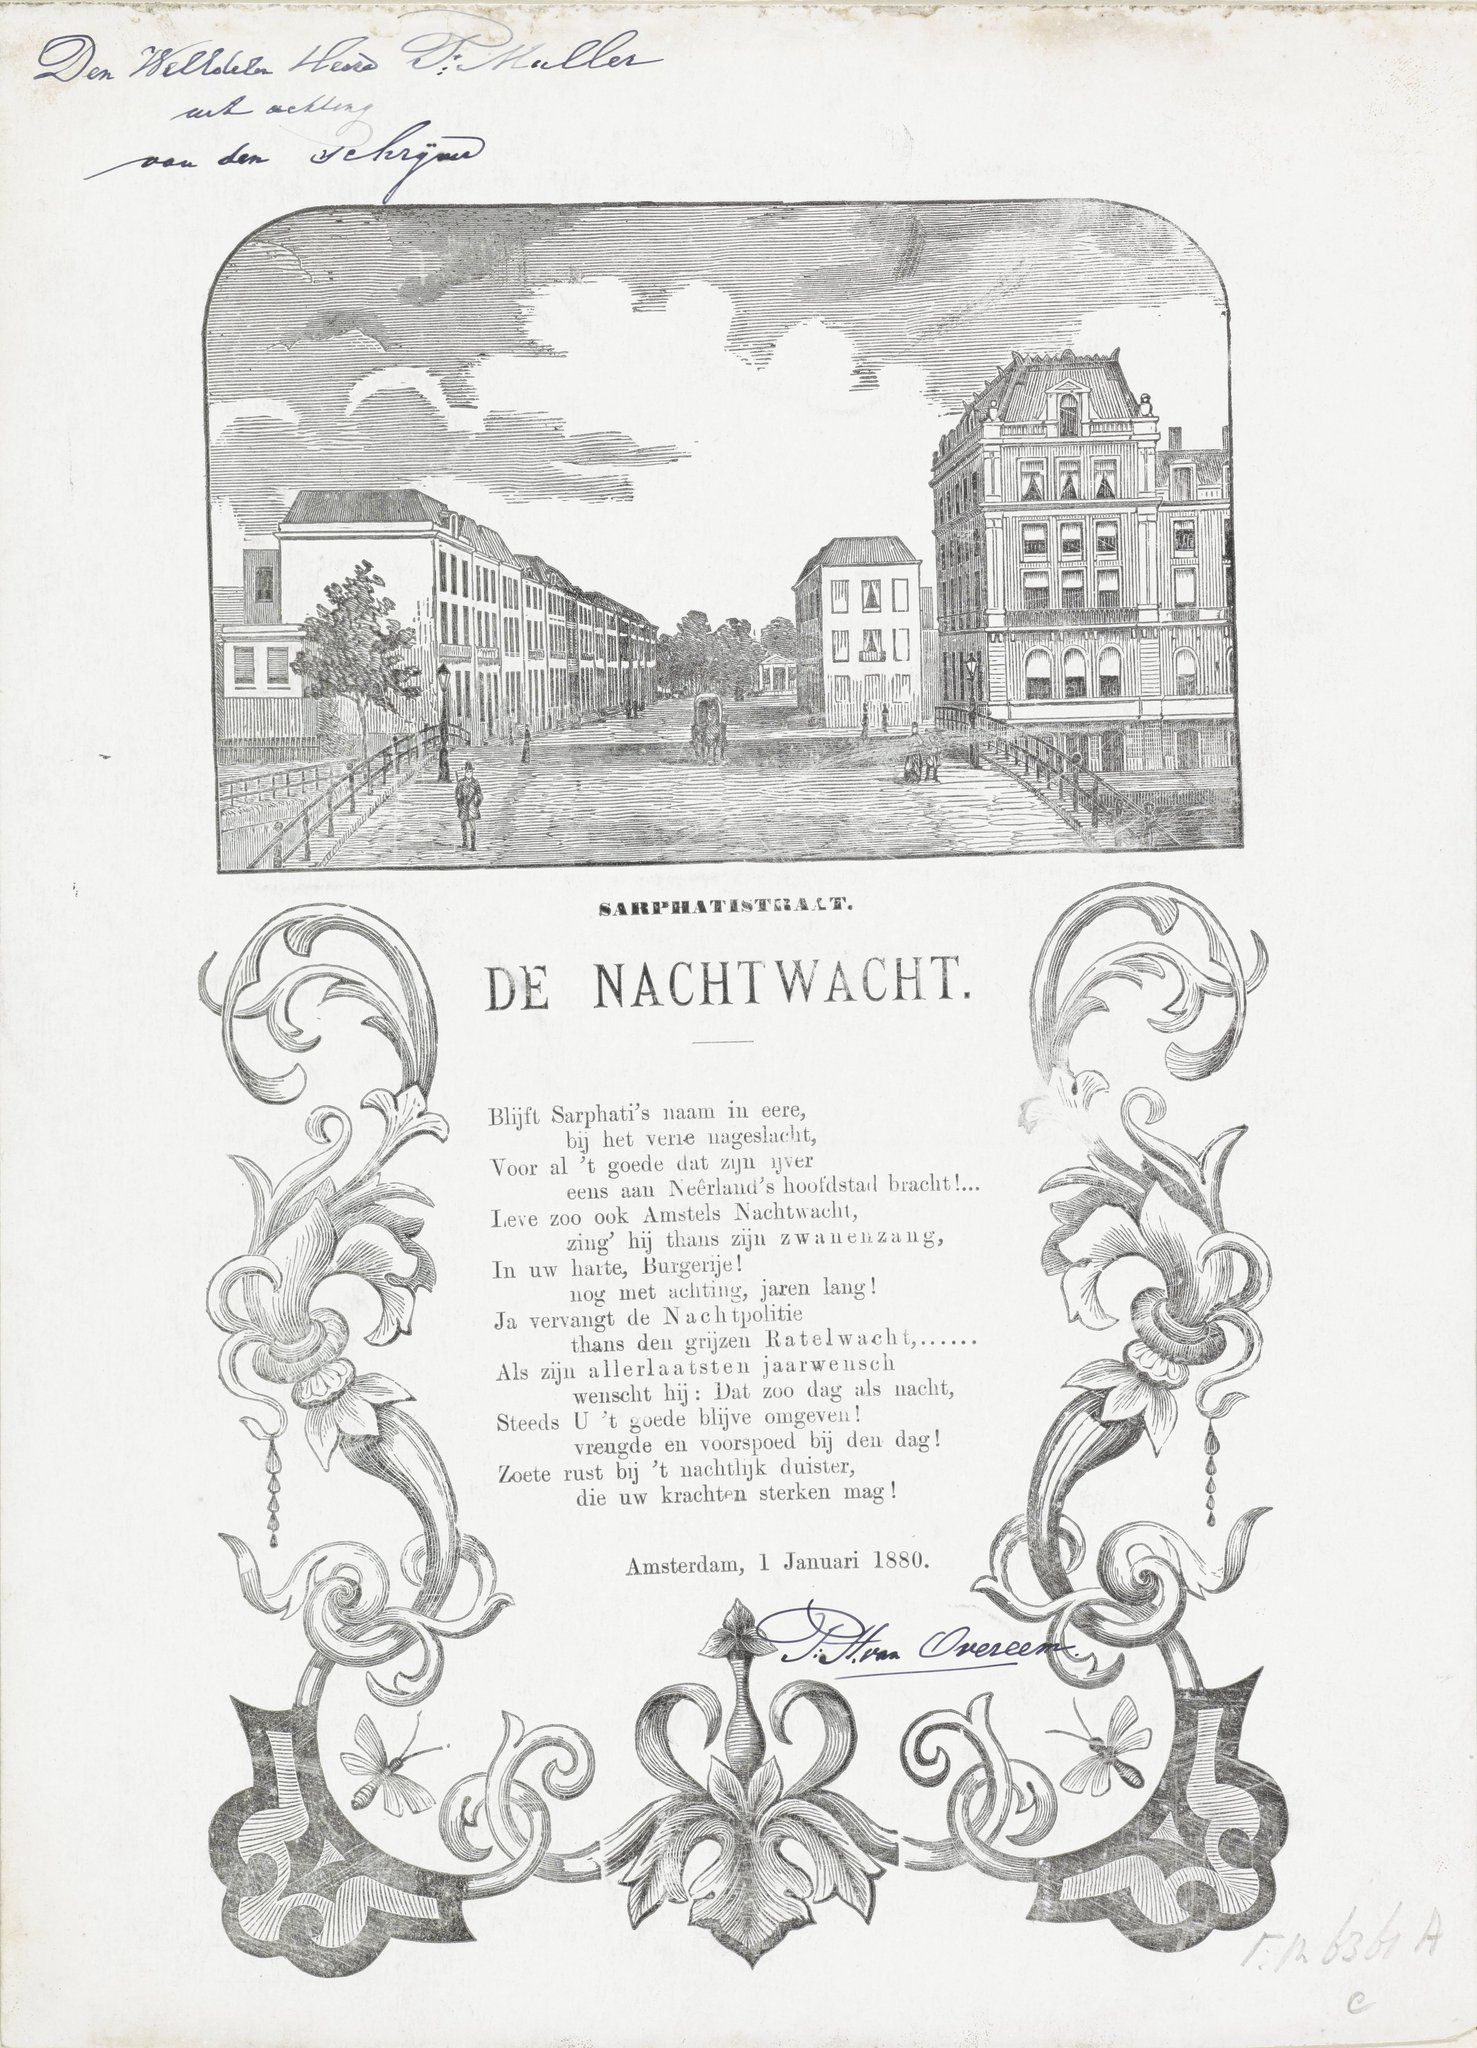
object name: new year card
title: De Nachtwacht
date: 1879-1880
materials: paper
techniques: letterpress printing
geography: amsterdam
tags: night patrol, street, amsterdam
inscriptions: collector's mark: Lugt 2228, signature: ‘PA van Overeem’, inscription: ‘Den WelEdelen Heer F Muller / uit achting / van den schrijver’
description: Nieuwjaarswens van de Amsterdamse nachtwacht (ratelwacht) voor het jaar 1880. Centraal een gedicht tussen bladranken. Bovenaan een gezicht op de Sarphatistraat gezien vanaf de Hogesluis. Rechts het Amstel Hotel.